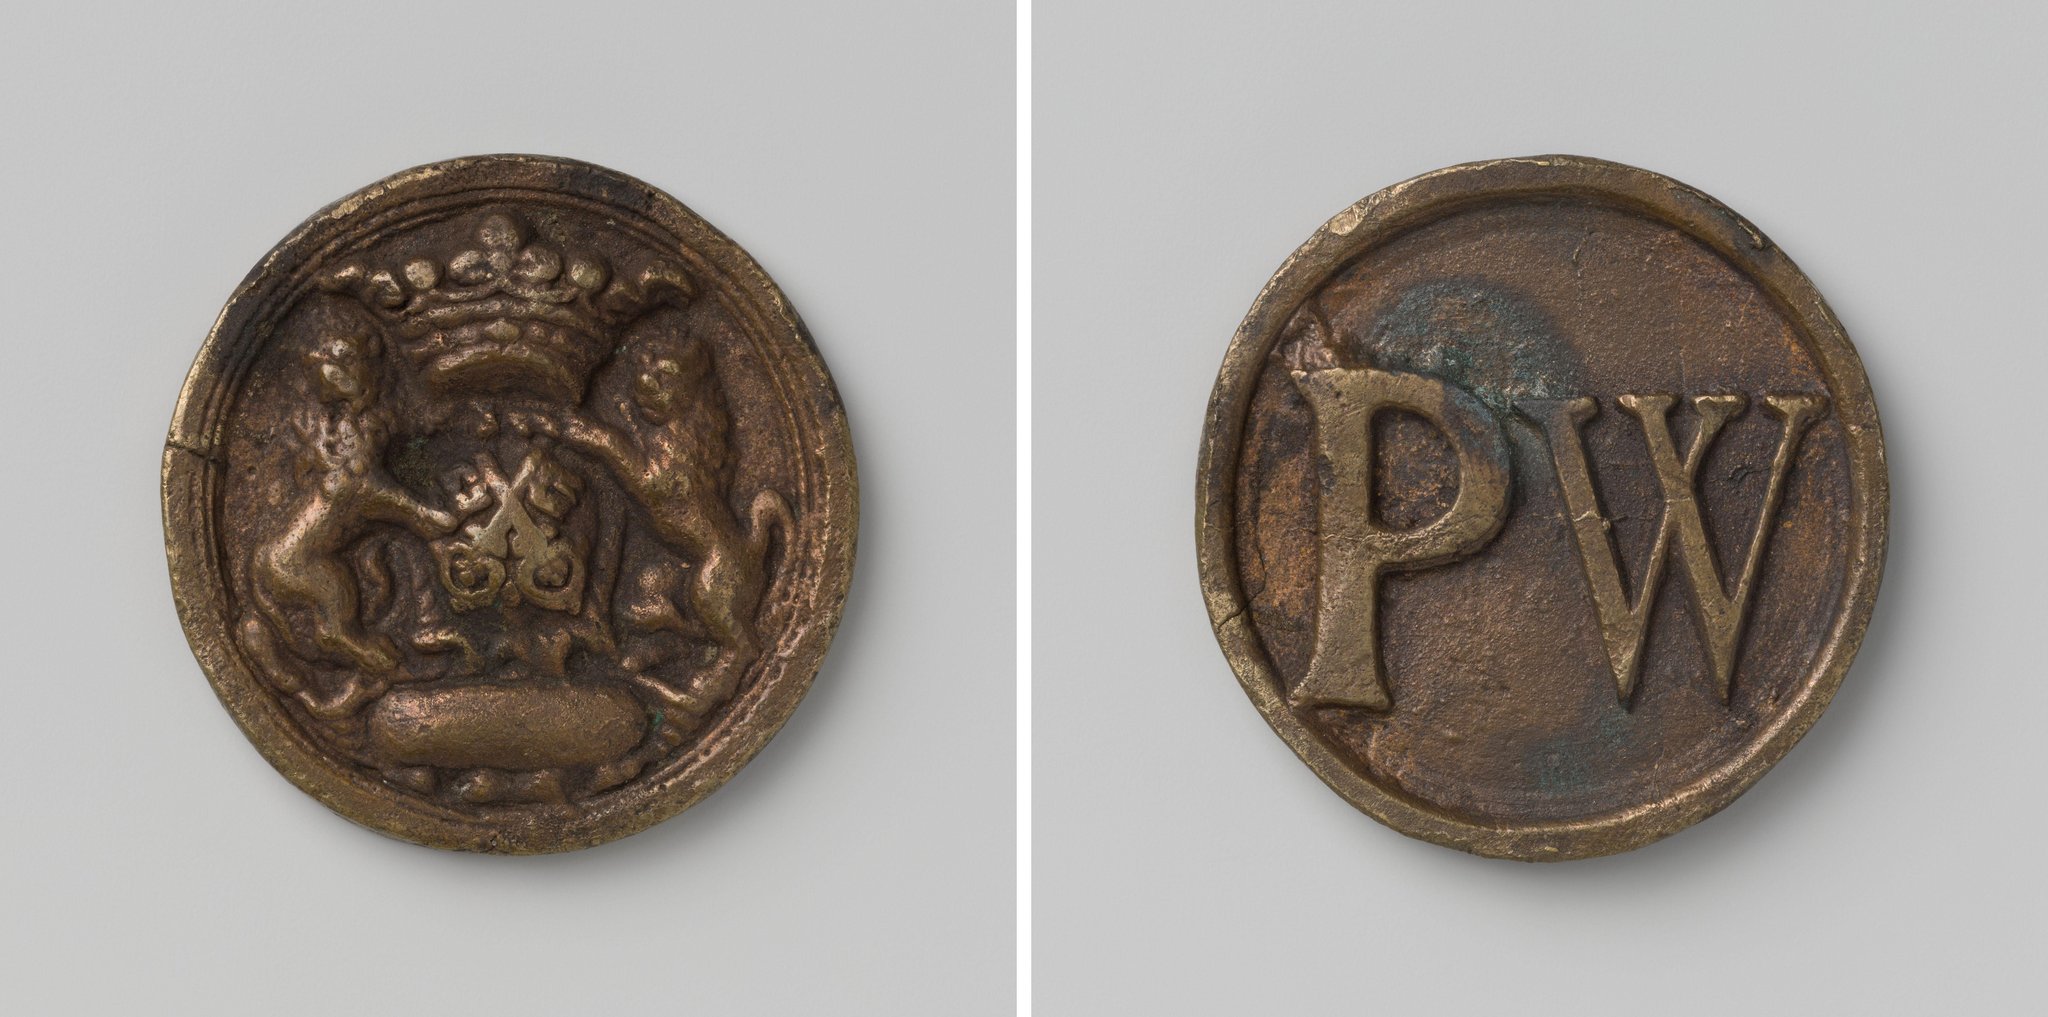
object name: fire engine medal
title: Leiden, brandspuitpenning met monogram P.W.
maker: Anonymous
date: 1680-1800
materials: brass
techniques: casting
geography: leiden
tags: leiden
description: Messing penning. Voorzijde: gekroond wapenschild, geflankeerd door twee leeuwen boven leeg compartiment. Keerzijde: monogram van letters P en W